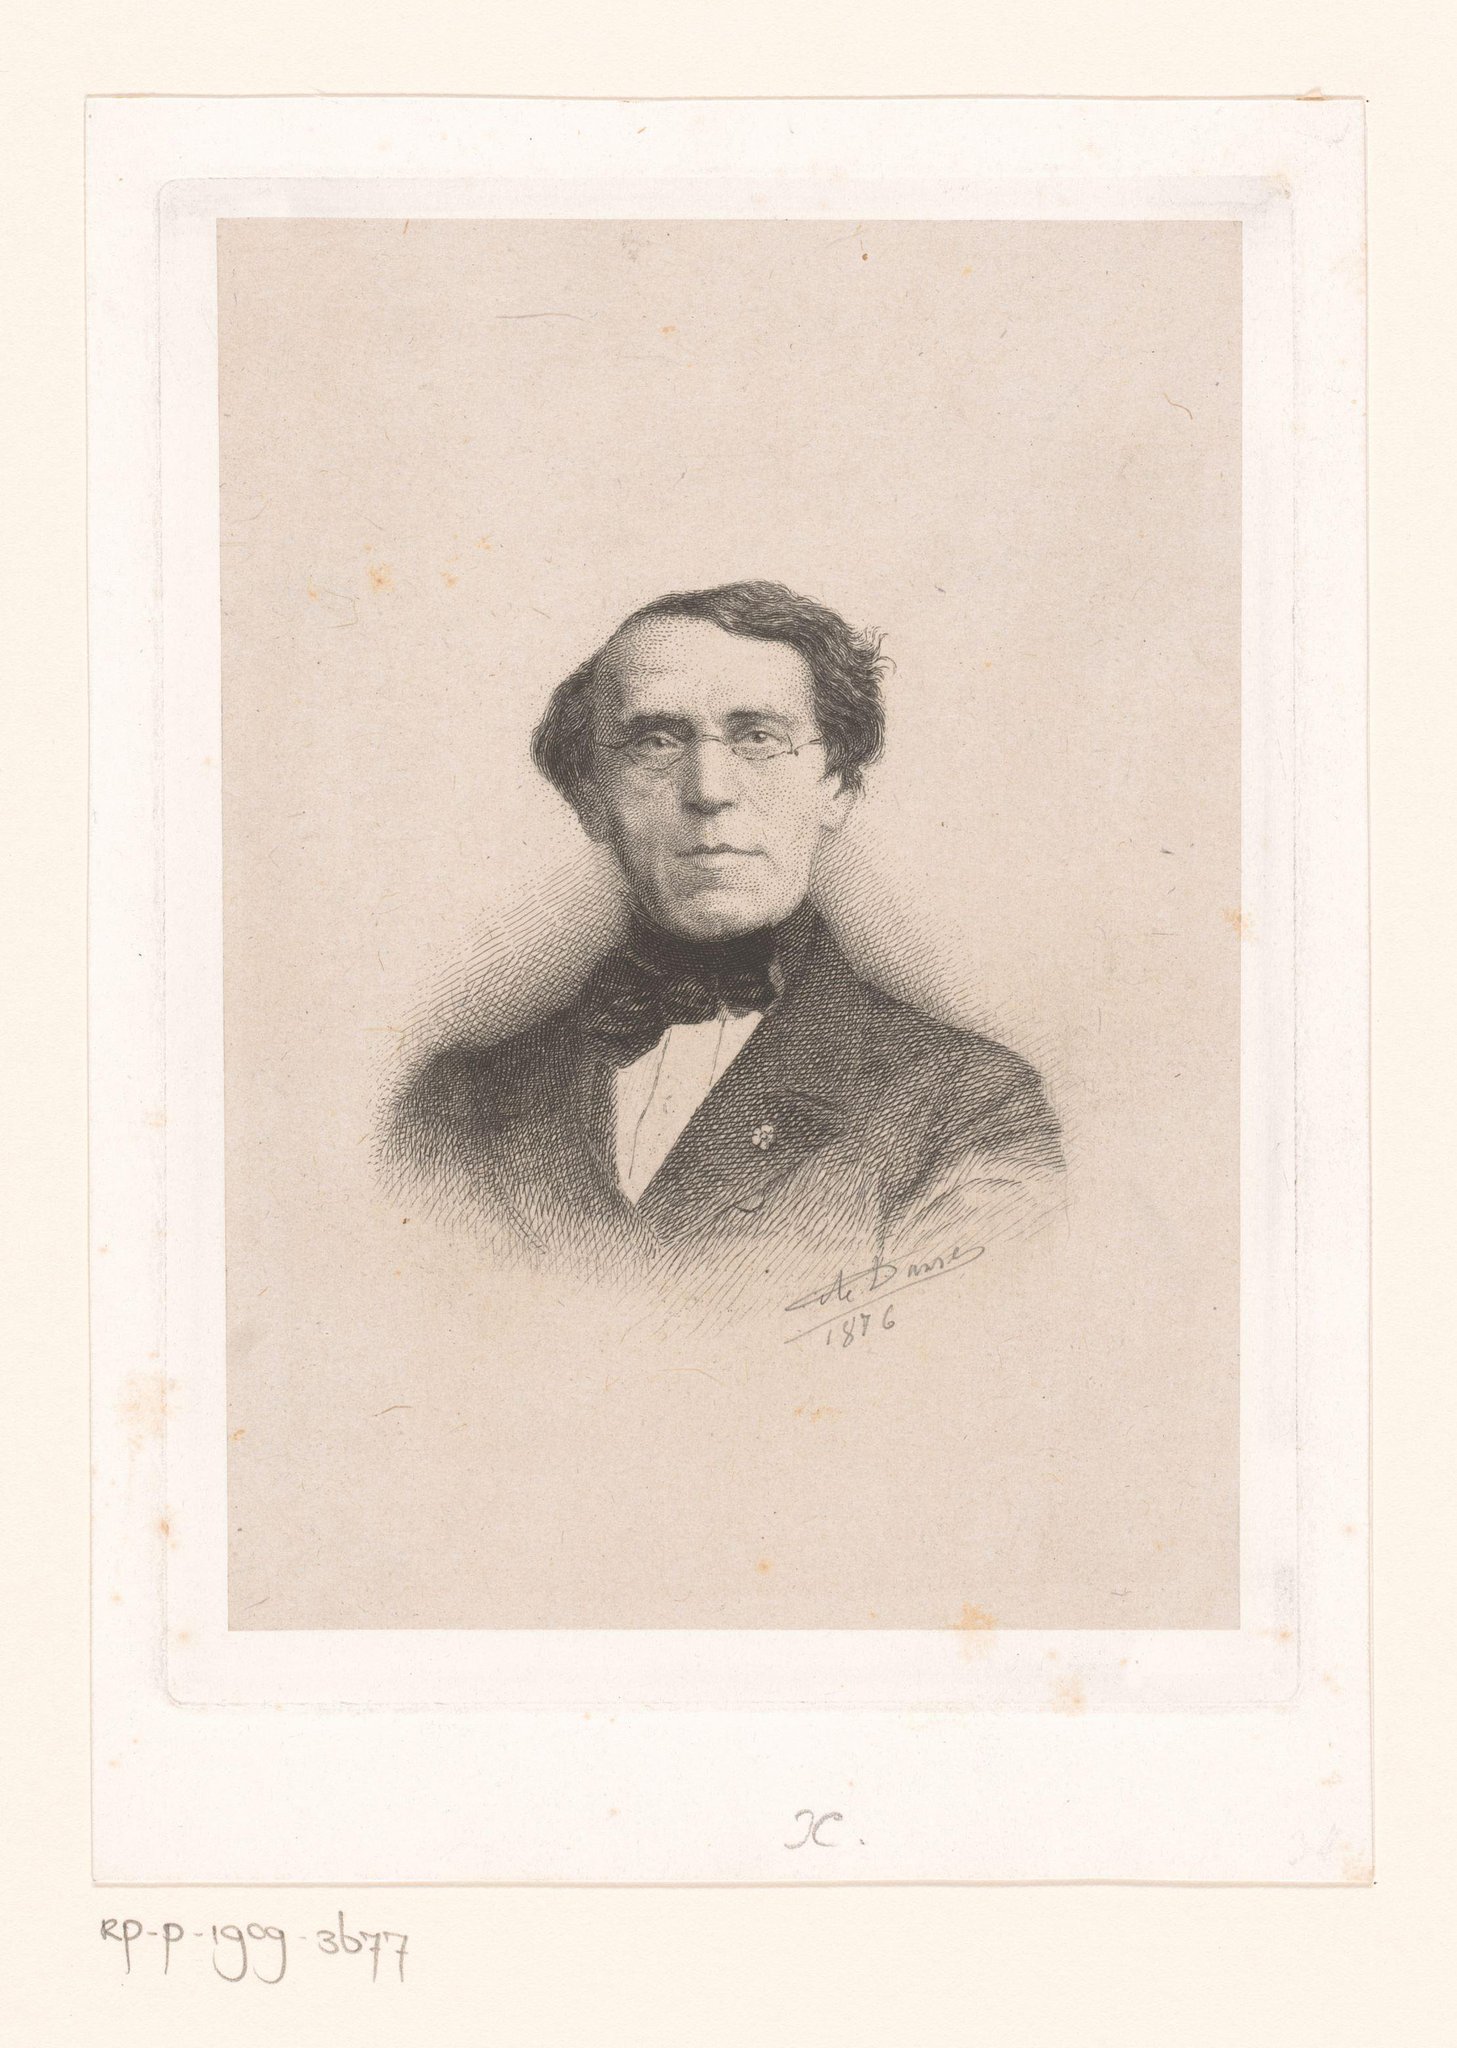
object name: print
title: Portret van een onbekende man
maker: auguste danse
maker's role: print maker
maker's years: 1829-1929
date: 1876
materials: paper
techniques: etching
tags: eyeglasses, spectacles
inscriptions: collector's mark: Lugt 2228